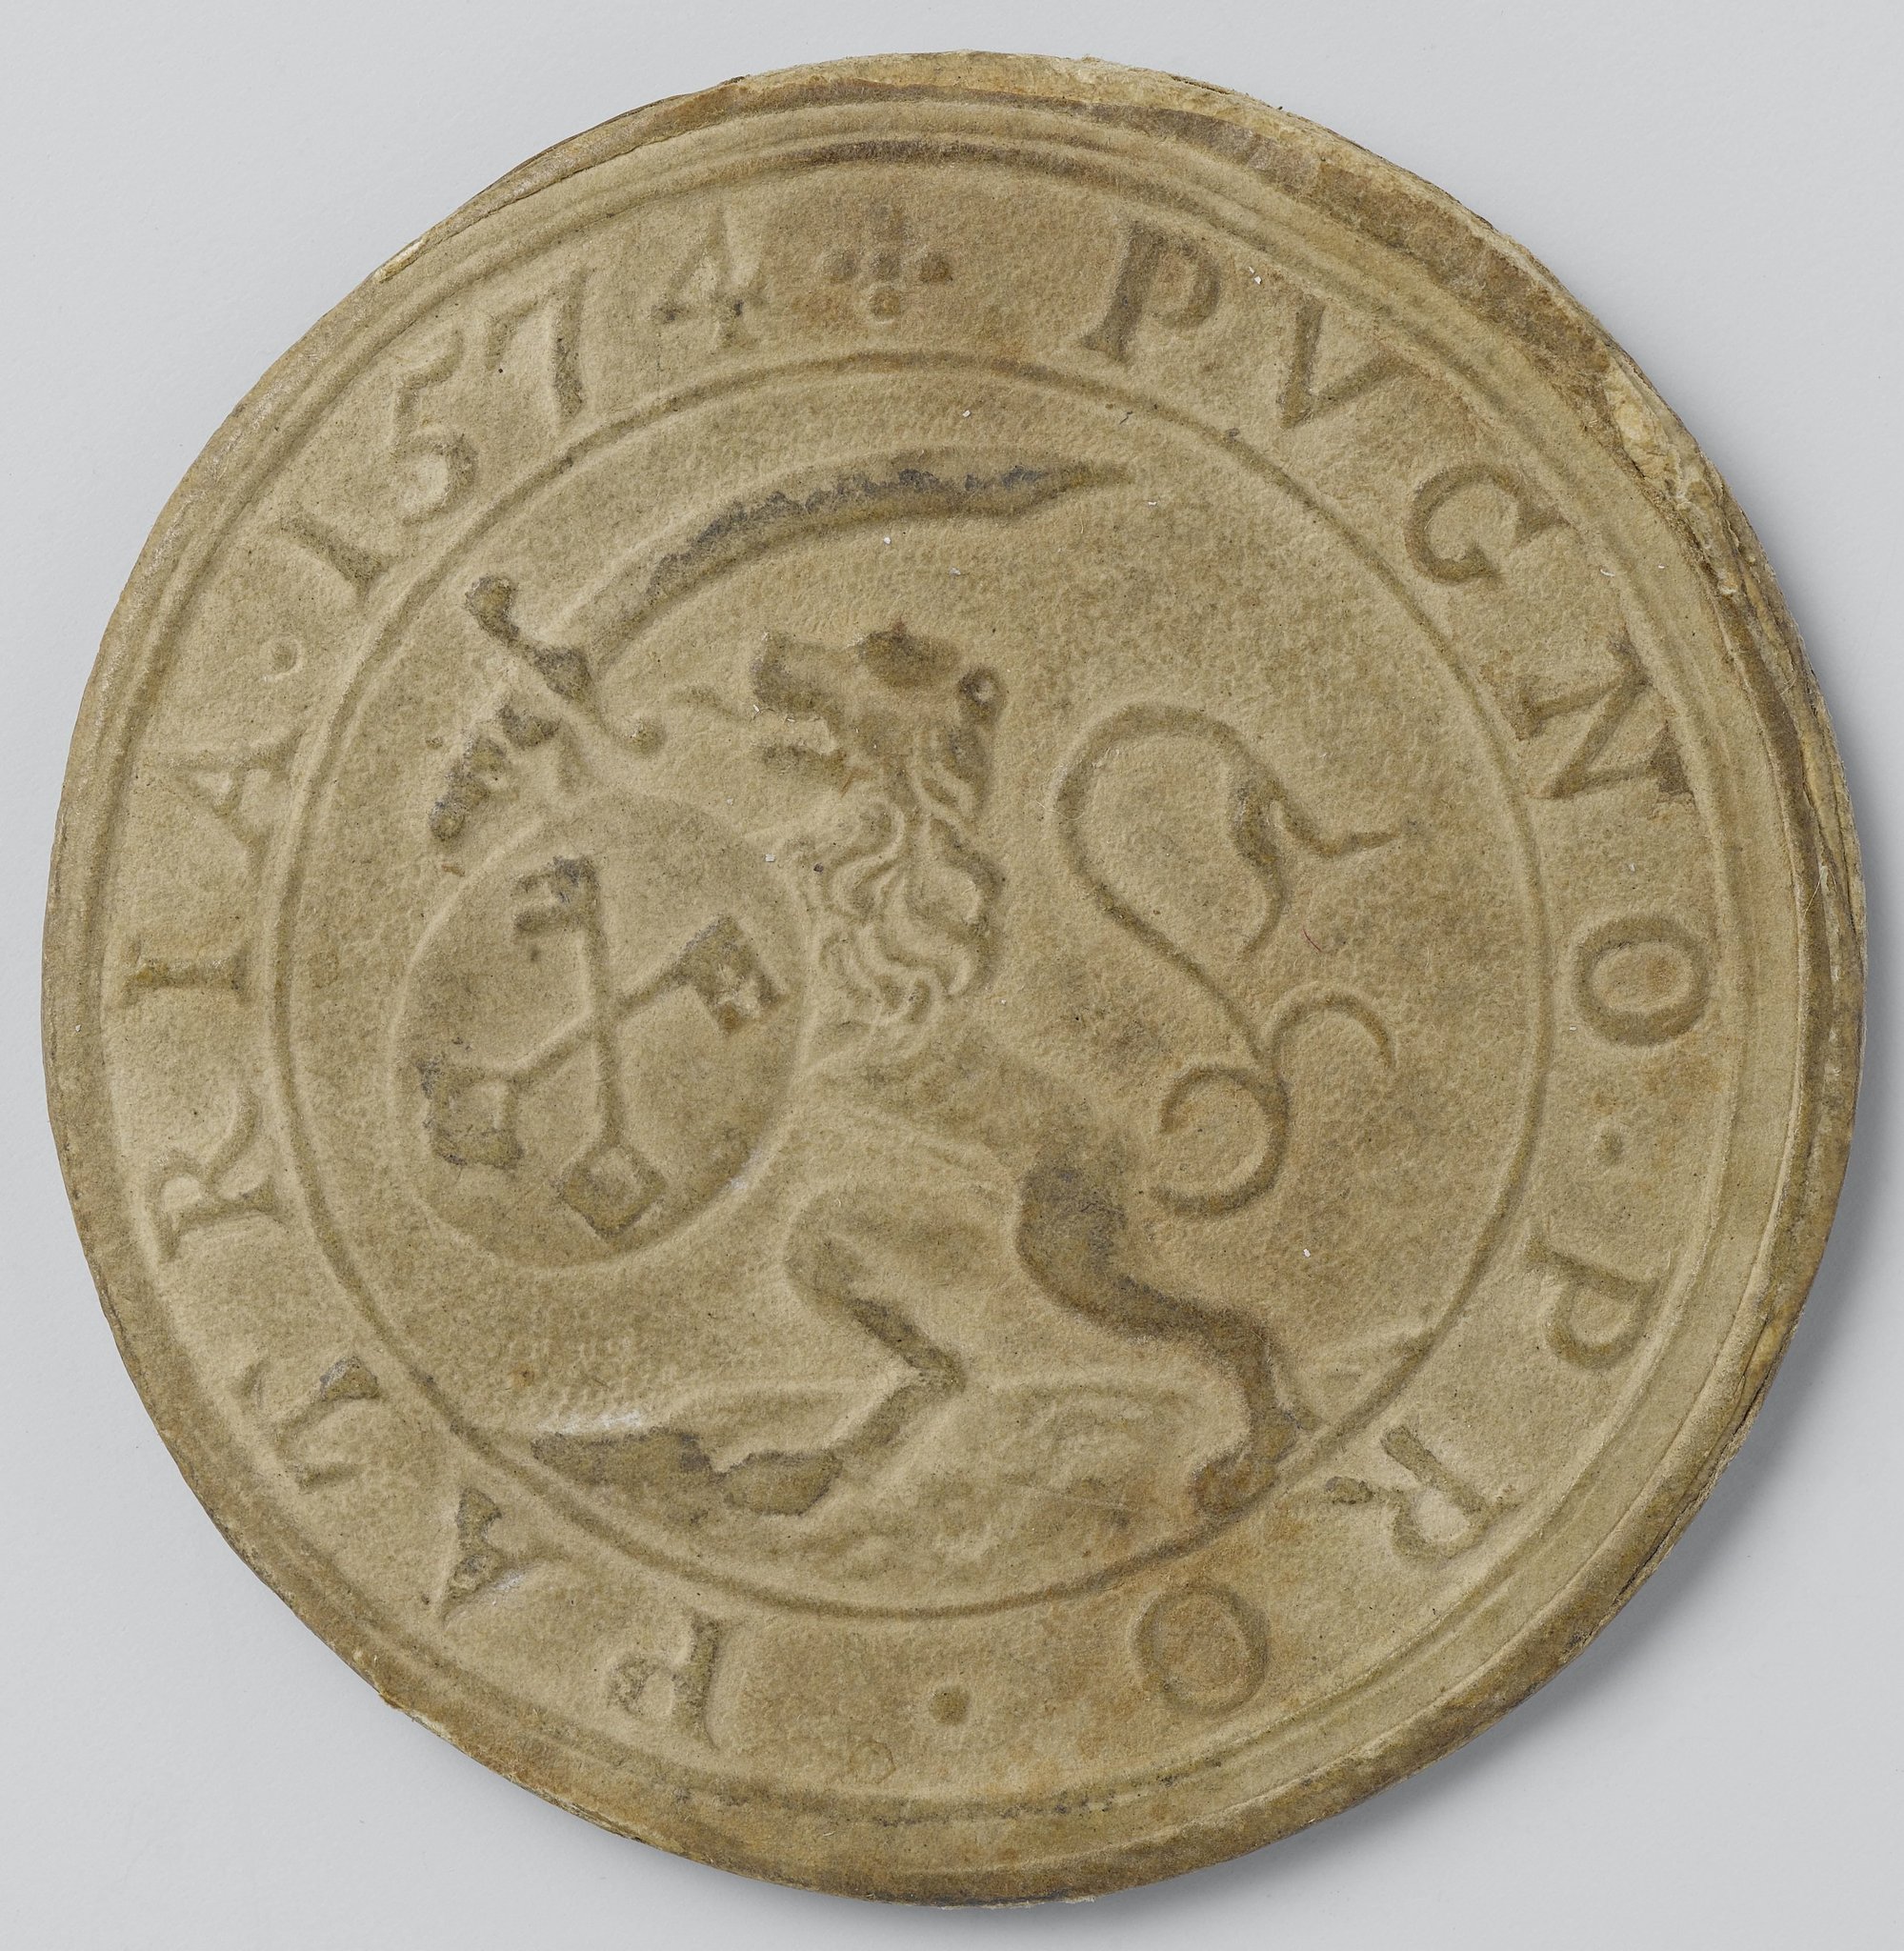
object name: achtentwintig stuiver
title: Achtentwintig stuiver, noodmunt uit Leiden, geslagen tijdens het tweede beleg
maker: Anonymous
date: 1600-1699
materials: paper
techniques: striking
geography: netherlands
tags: leiden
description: Papieren munt. Voorzijde: leeuw met boven hoofd geheven zwaard in rechter- en stadswapenschild in linkerklauw binnen omschrift. Keerzijde: opschrift binnen lauwerkrans.